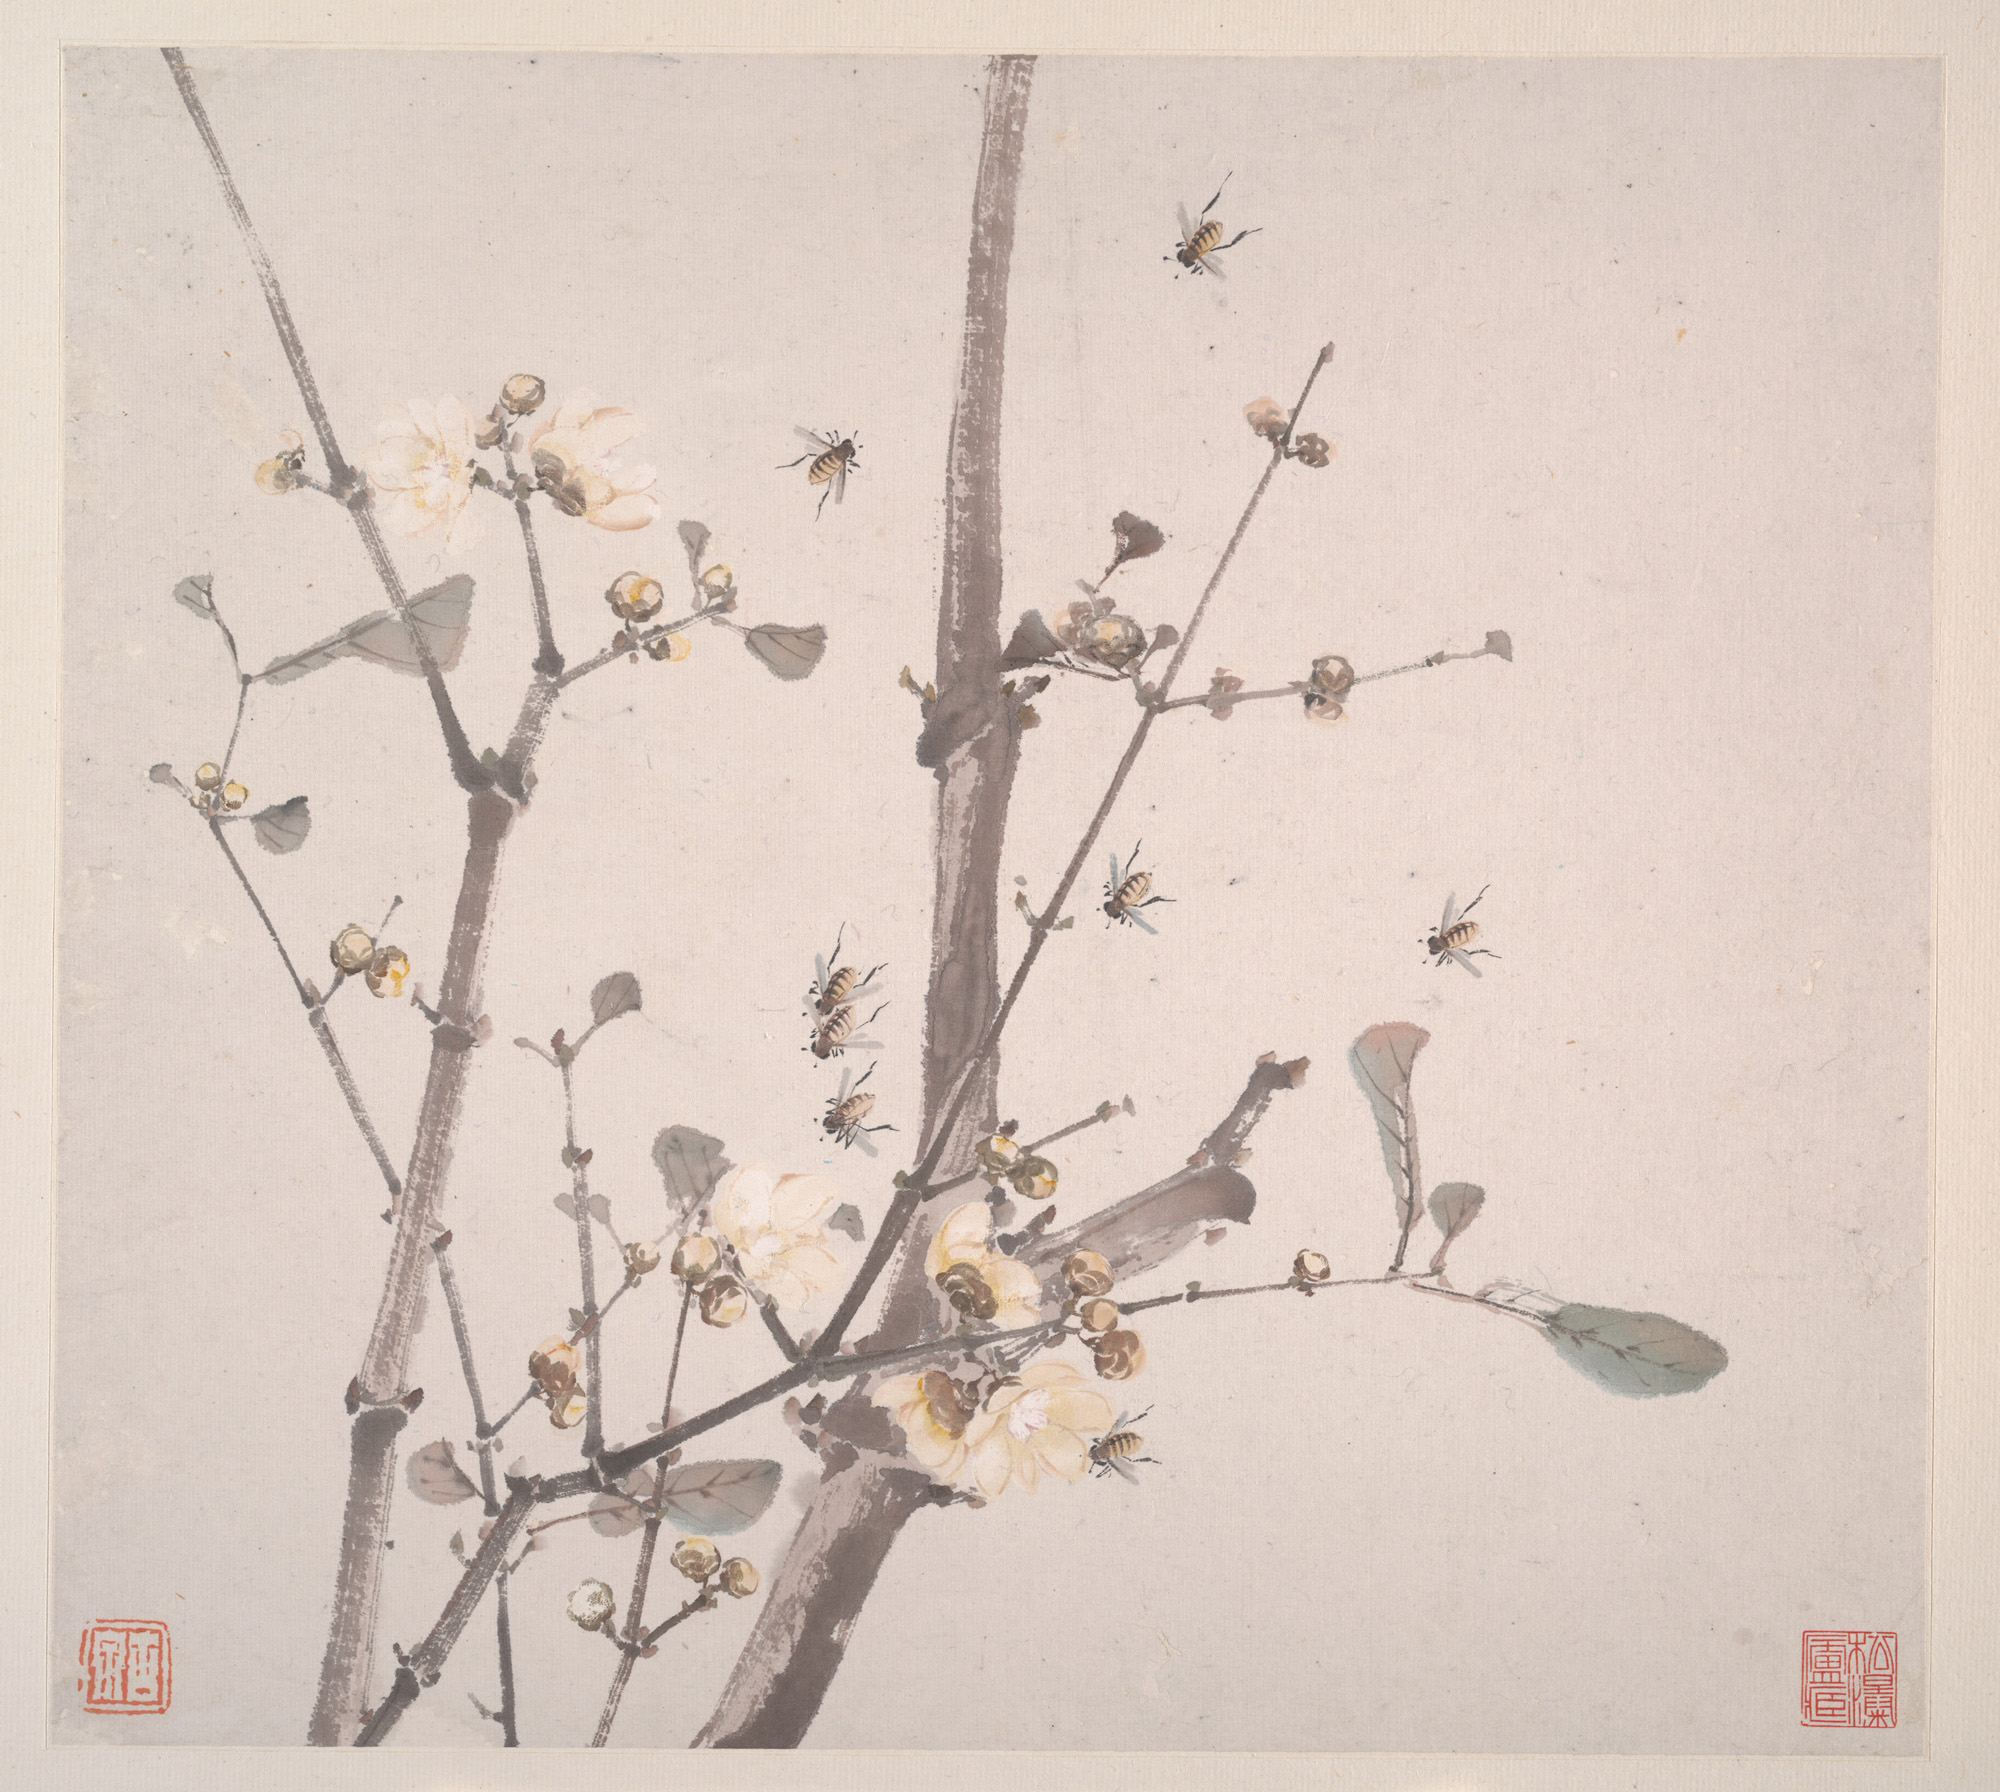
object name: album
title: Insects and Flowers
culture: chinese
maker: ju lian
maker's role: artist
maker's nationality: chinese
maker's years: 1828-1904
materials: ink, paper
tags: insects,flowers